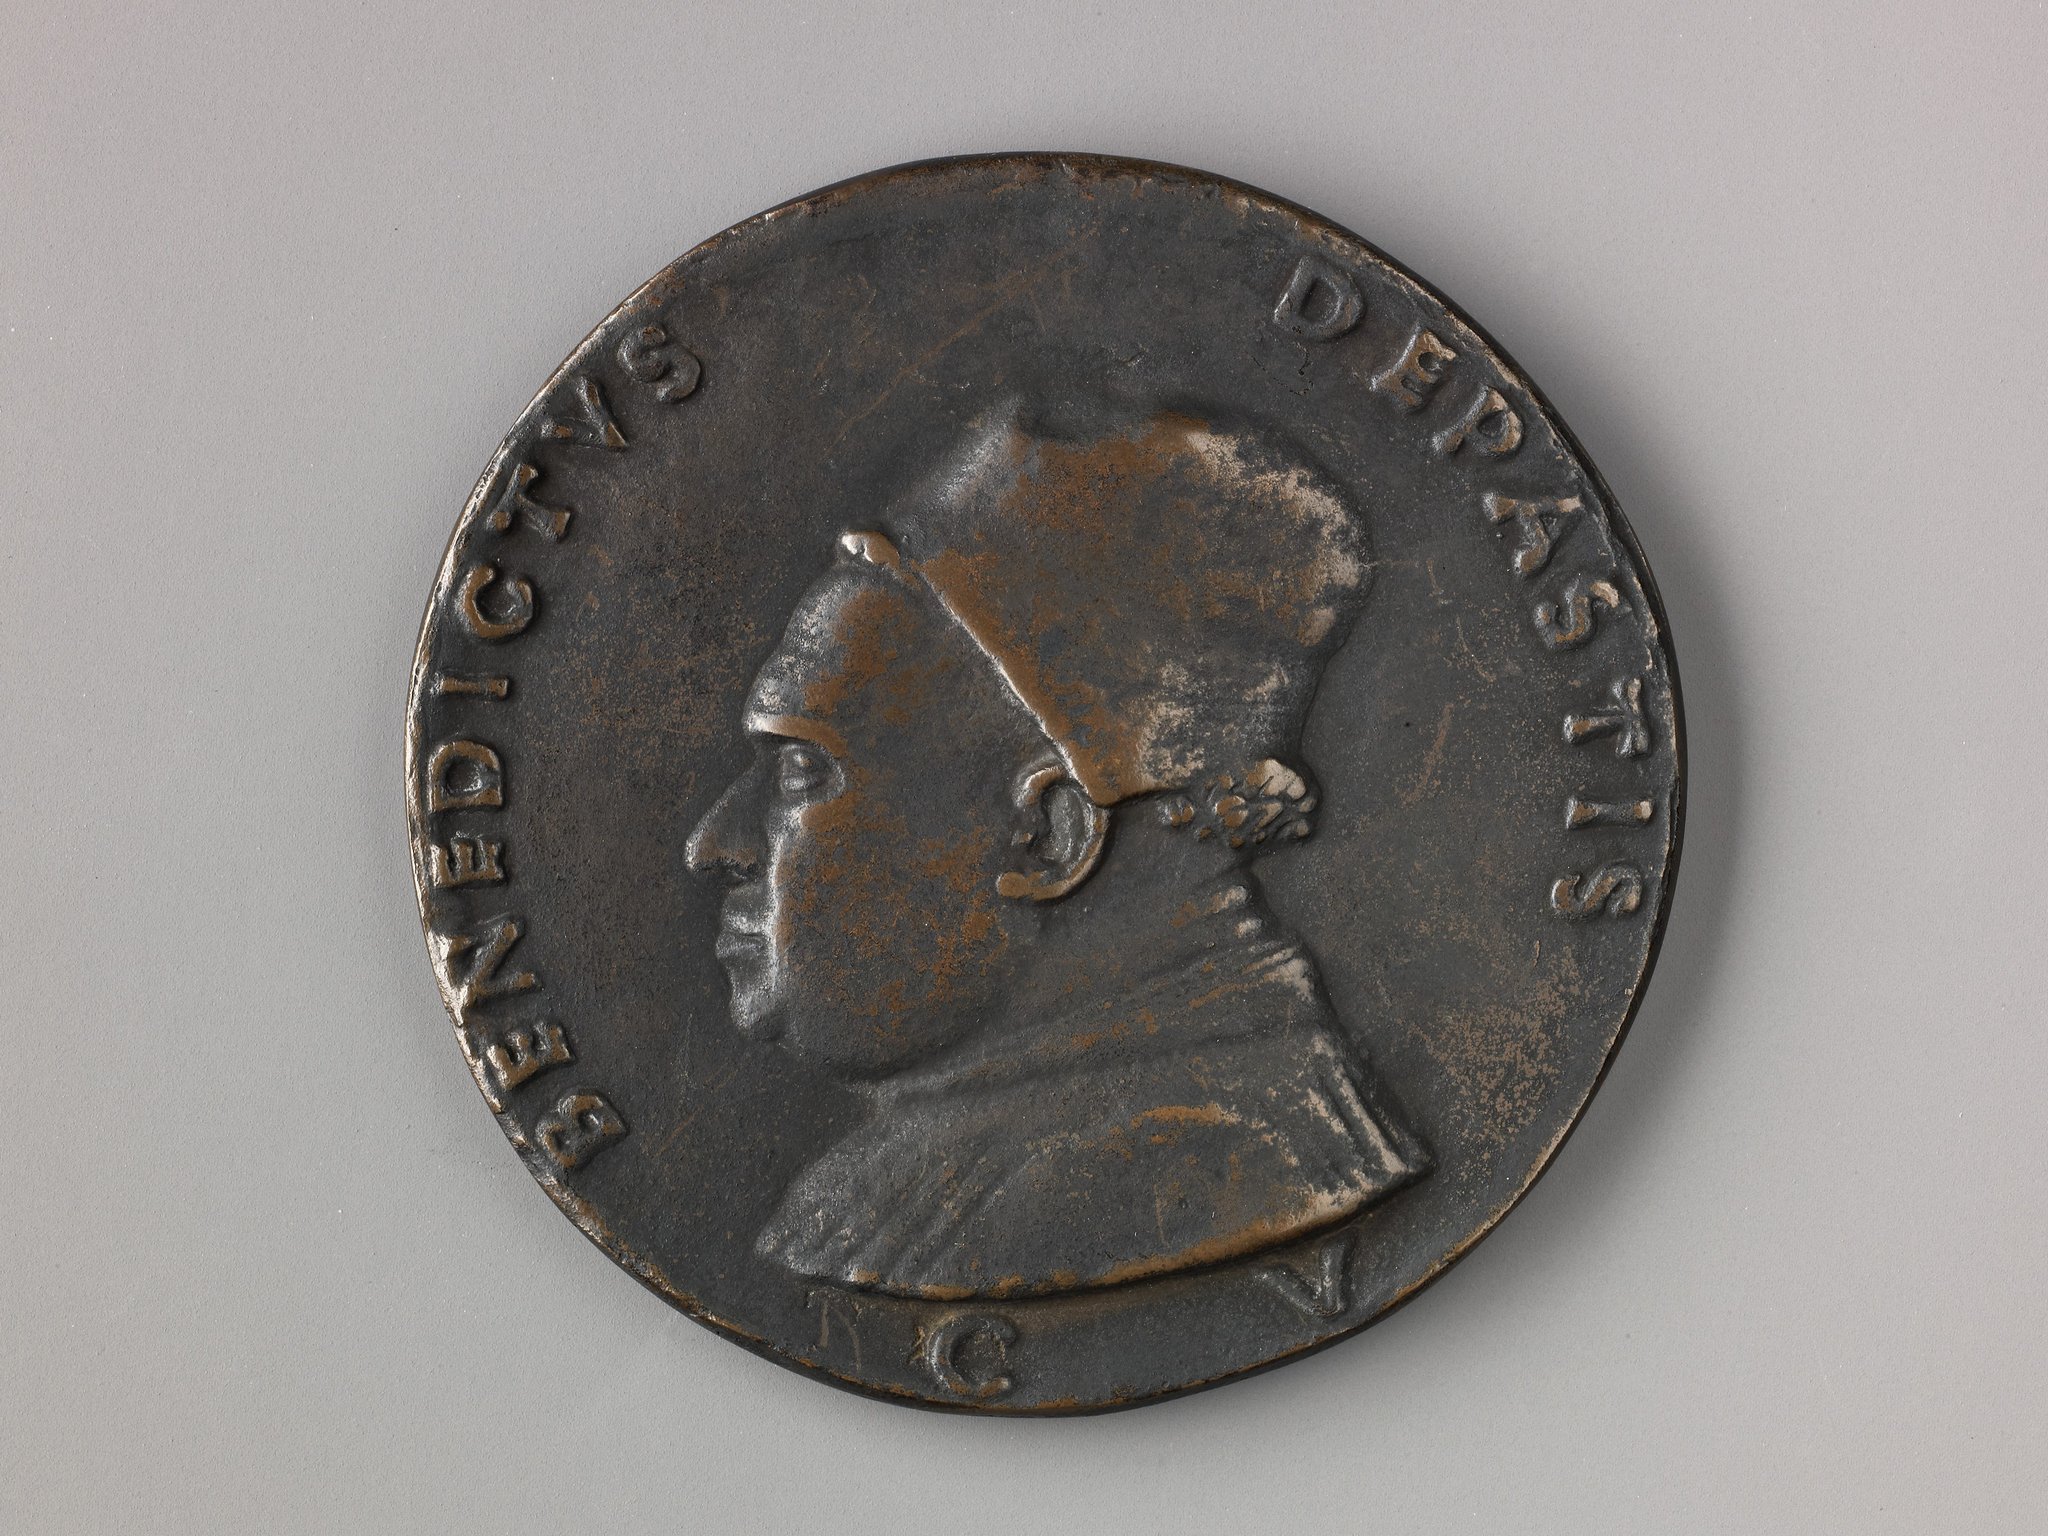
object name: medal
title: Medal: Benedetto de Pasti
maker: matteo de' pasti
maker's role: artist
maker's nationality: italian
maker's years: 1420-1467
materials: copper alloy, patina, wax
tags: men,portraits